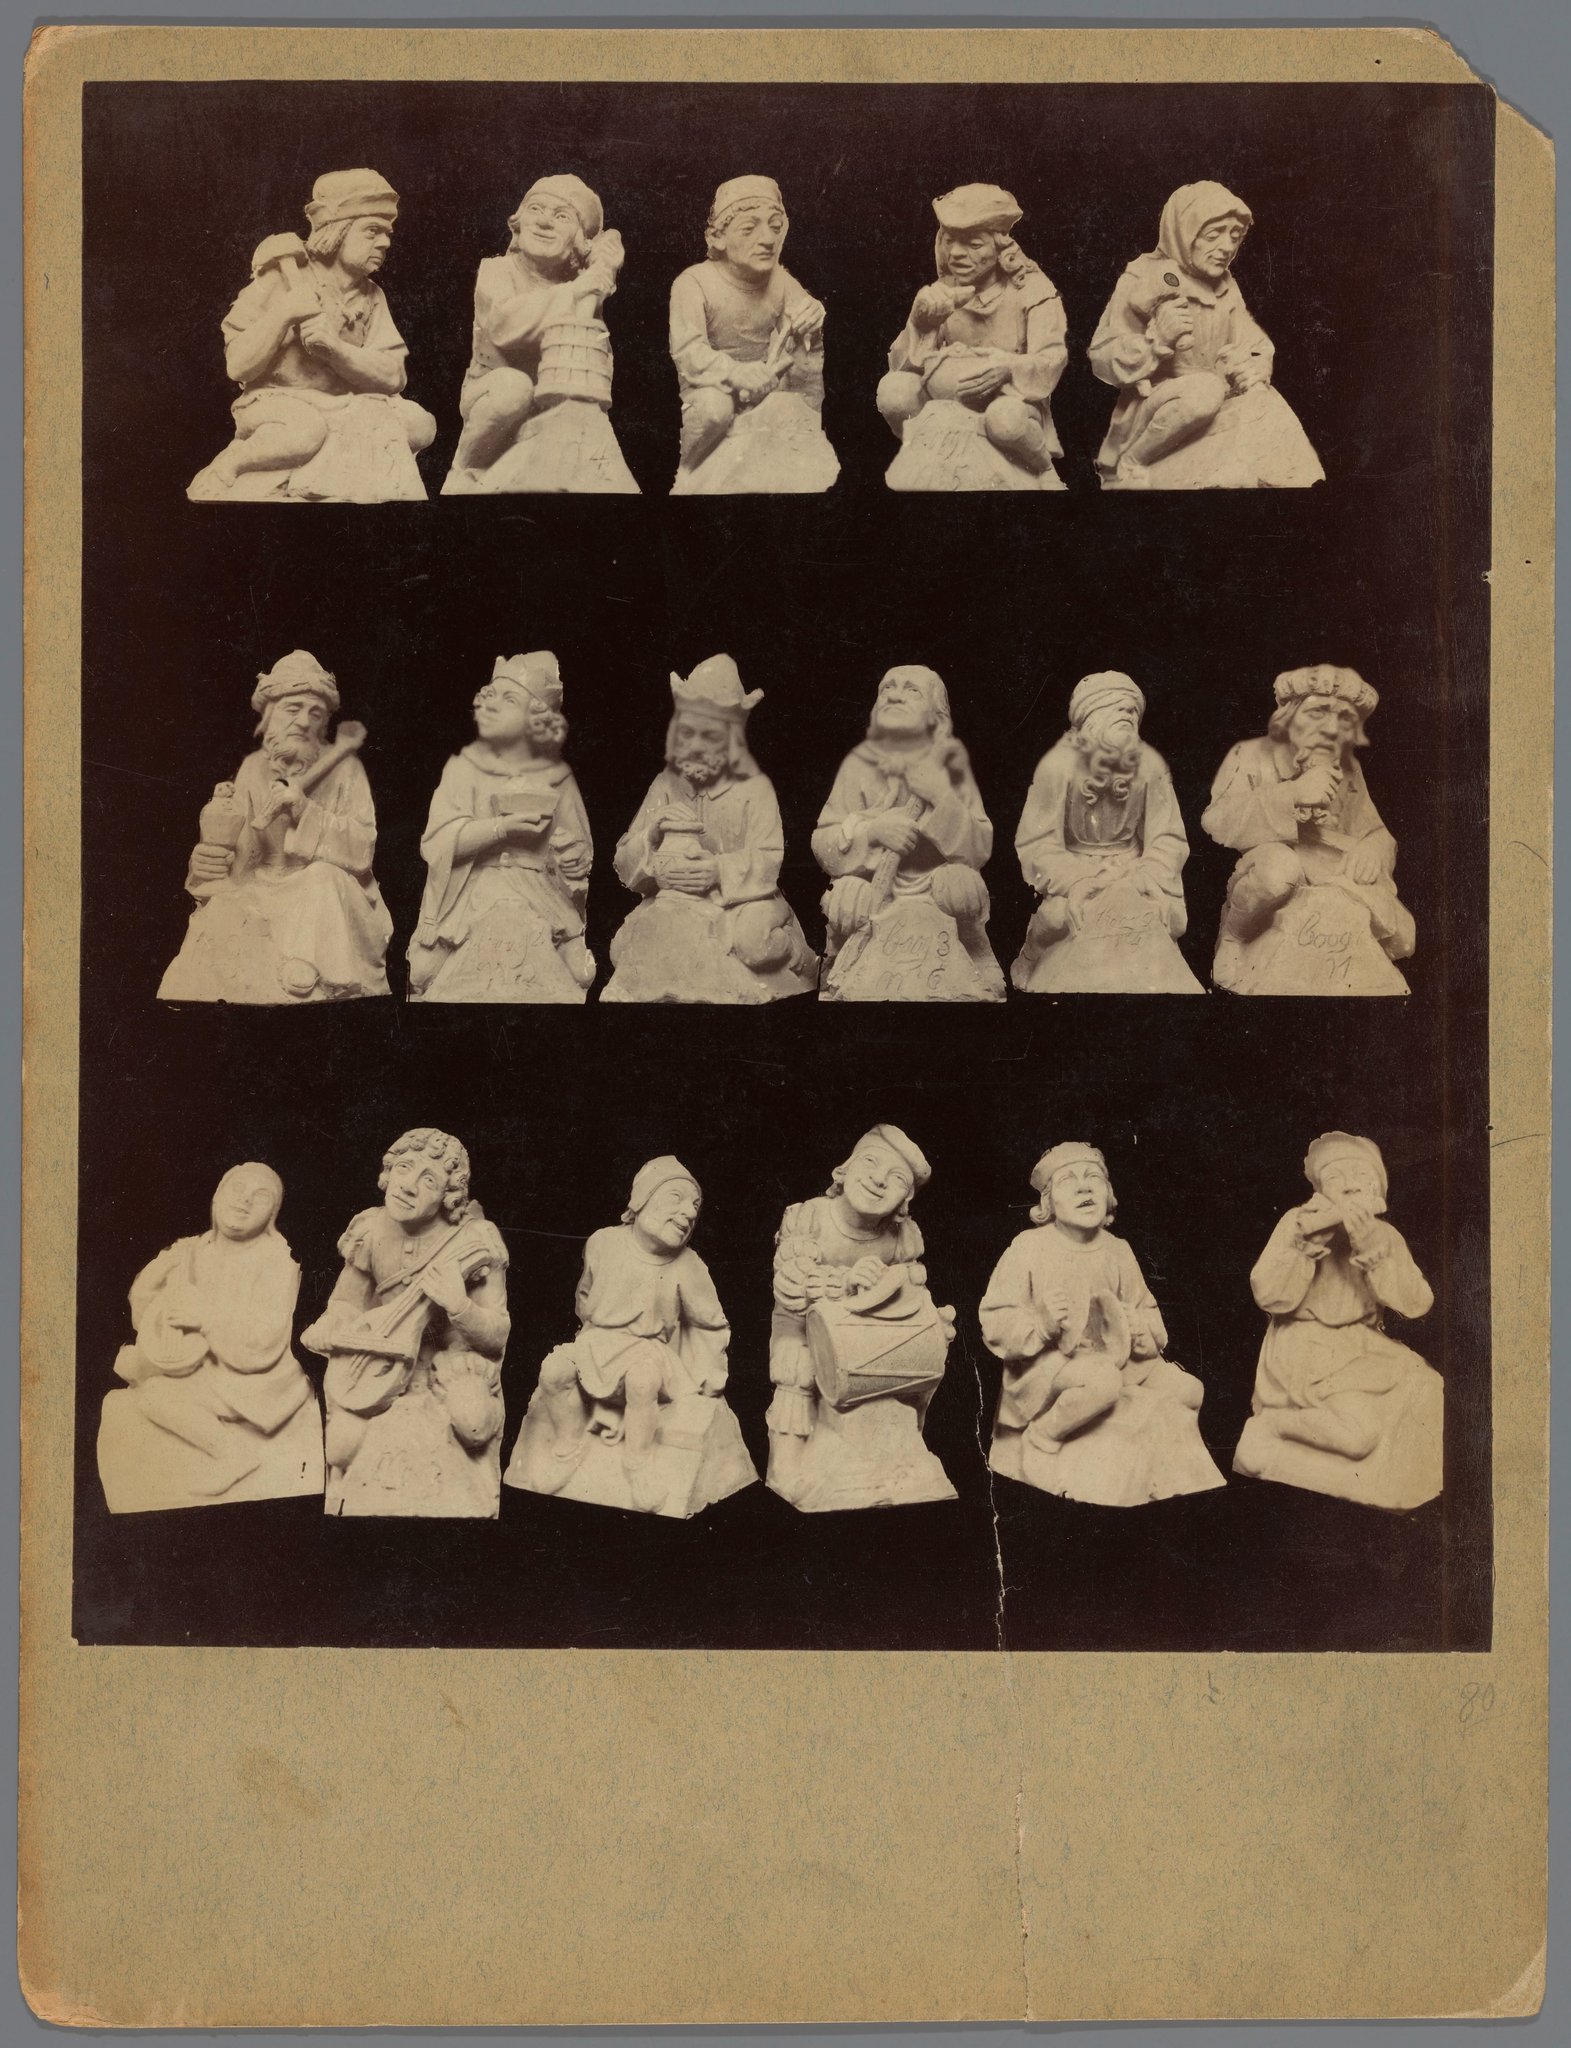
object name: photograph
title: Zeventien luchtboogfiguren van de Sint-Janskathedraal te 's-Hertogenbosch in de vorm van werkende en musicerende mannen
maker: Anonymous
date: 1875-1900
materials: cardboard, photographic support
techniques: albumen print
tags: musician at work, working class, labourers, sculpture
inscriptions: name: ‘Kunstboekhandel J. A. G. de Leur photograaf-uitgever Huigenspark 40b. Den Haag.’, number: ‘80’, collector's mark: Lugt 3937